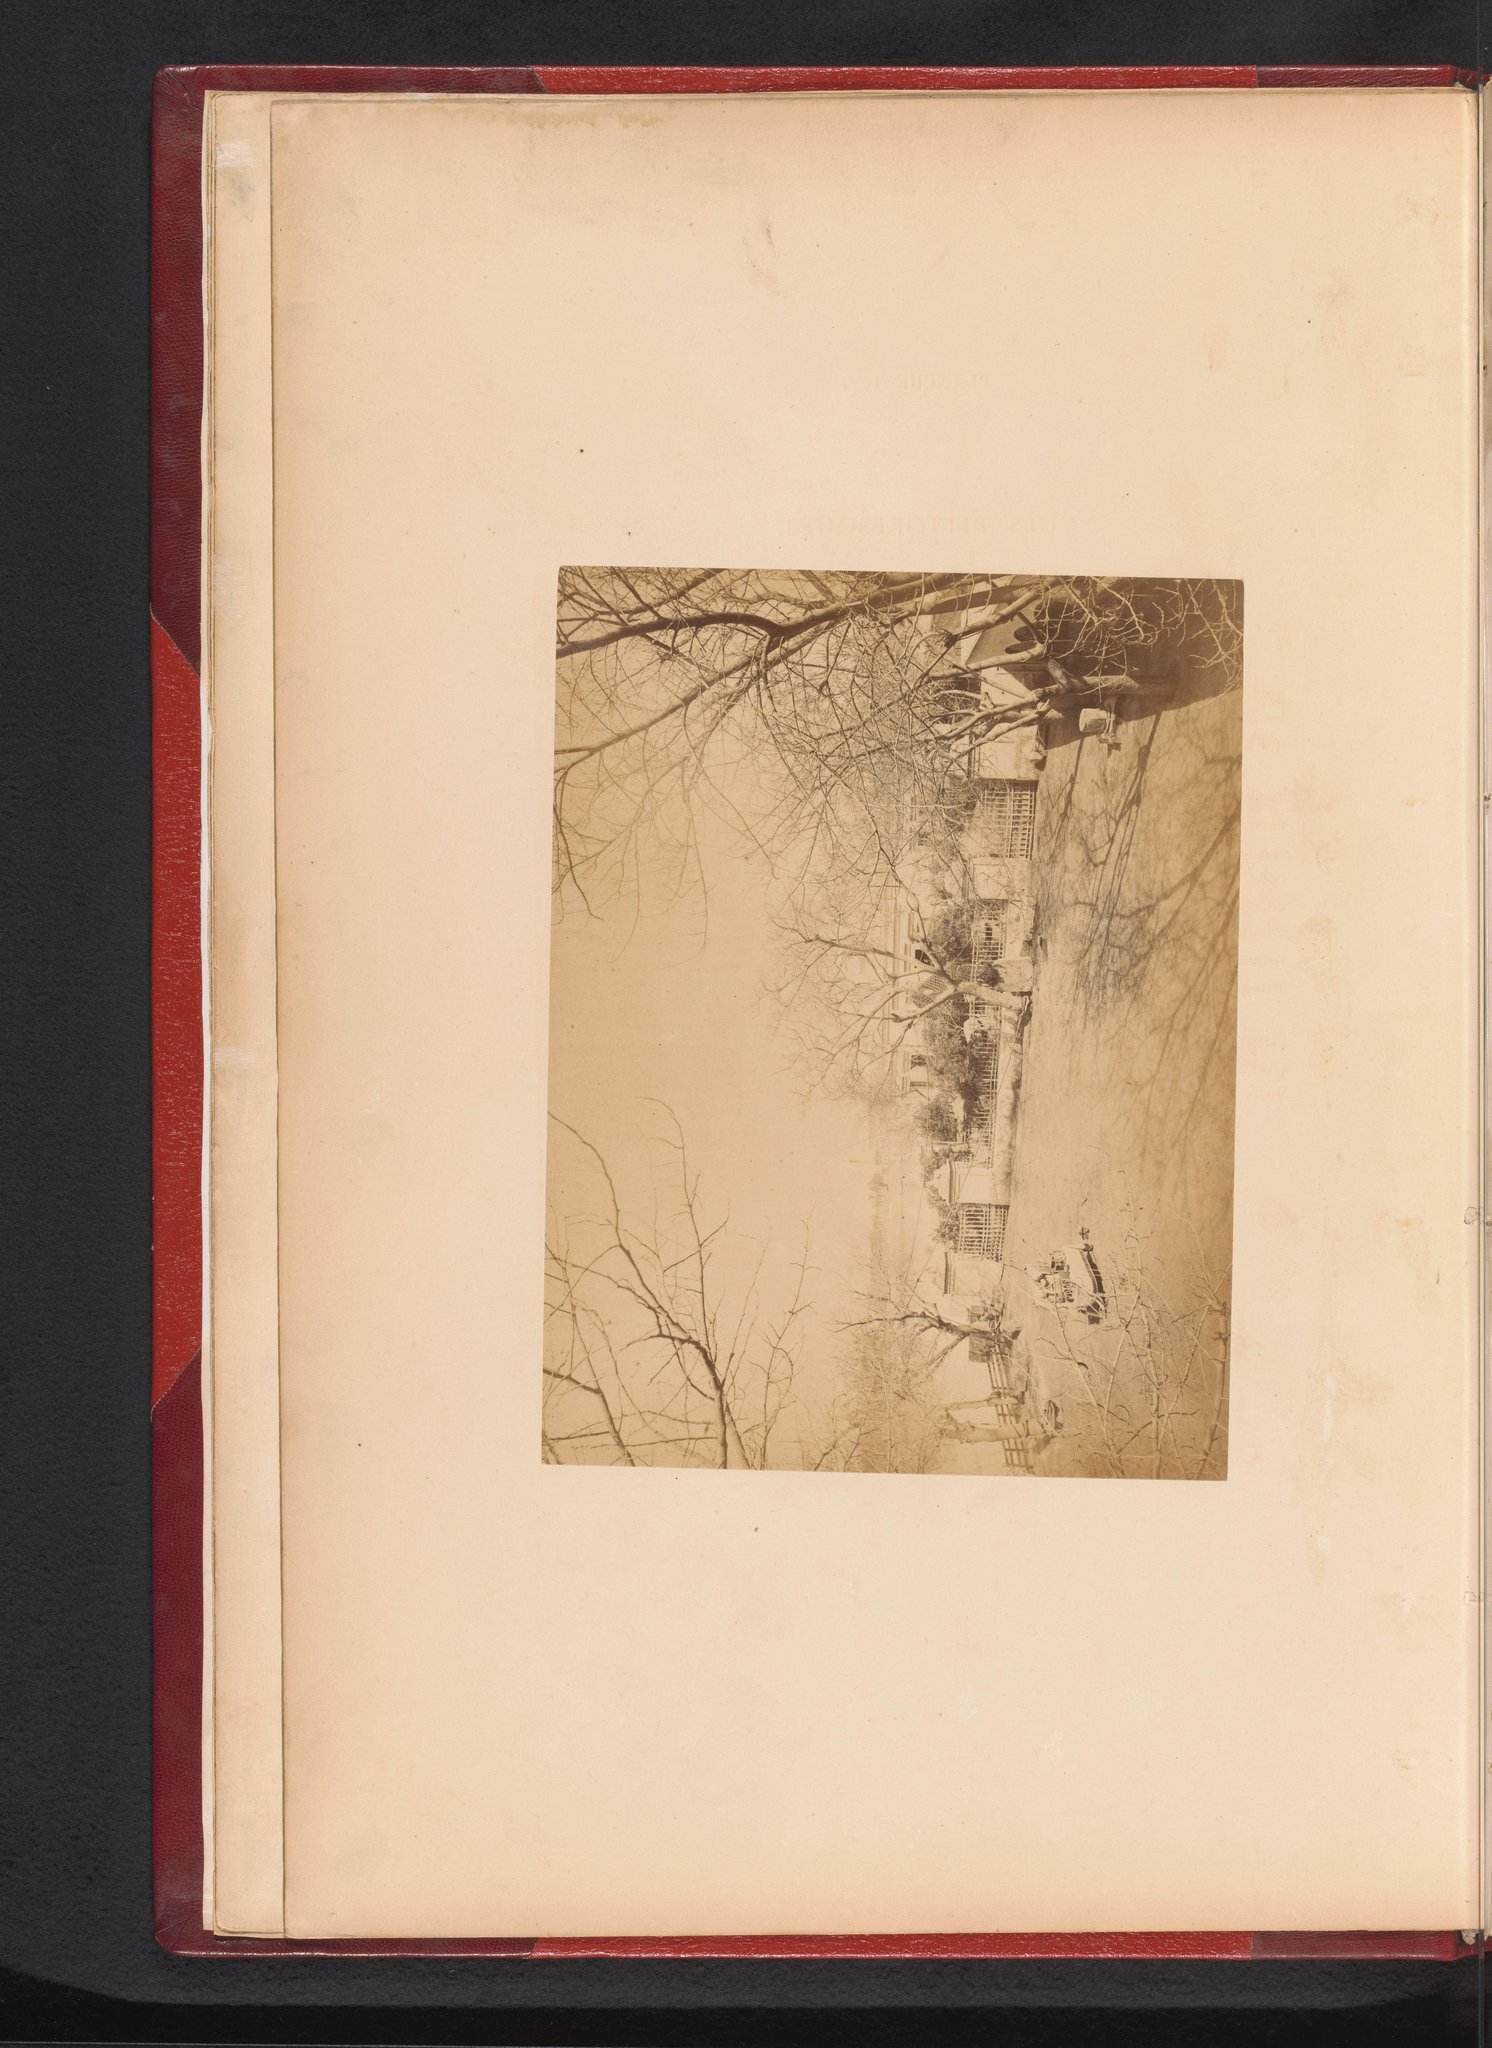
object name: photograph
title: Gezicht op het plein voor het Boulaq Museum in Caïro, Egypte, met aan de linkerkant de Nijl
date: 1866-1871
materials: photographic support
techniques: albumen print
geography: cairo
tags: river, courtyard